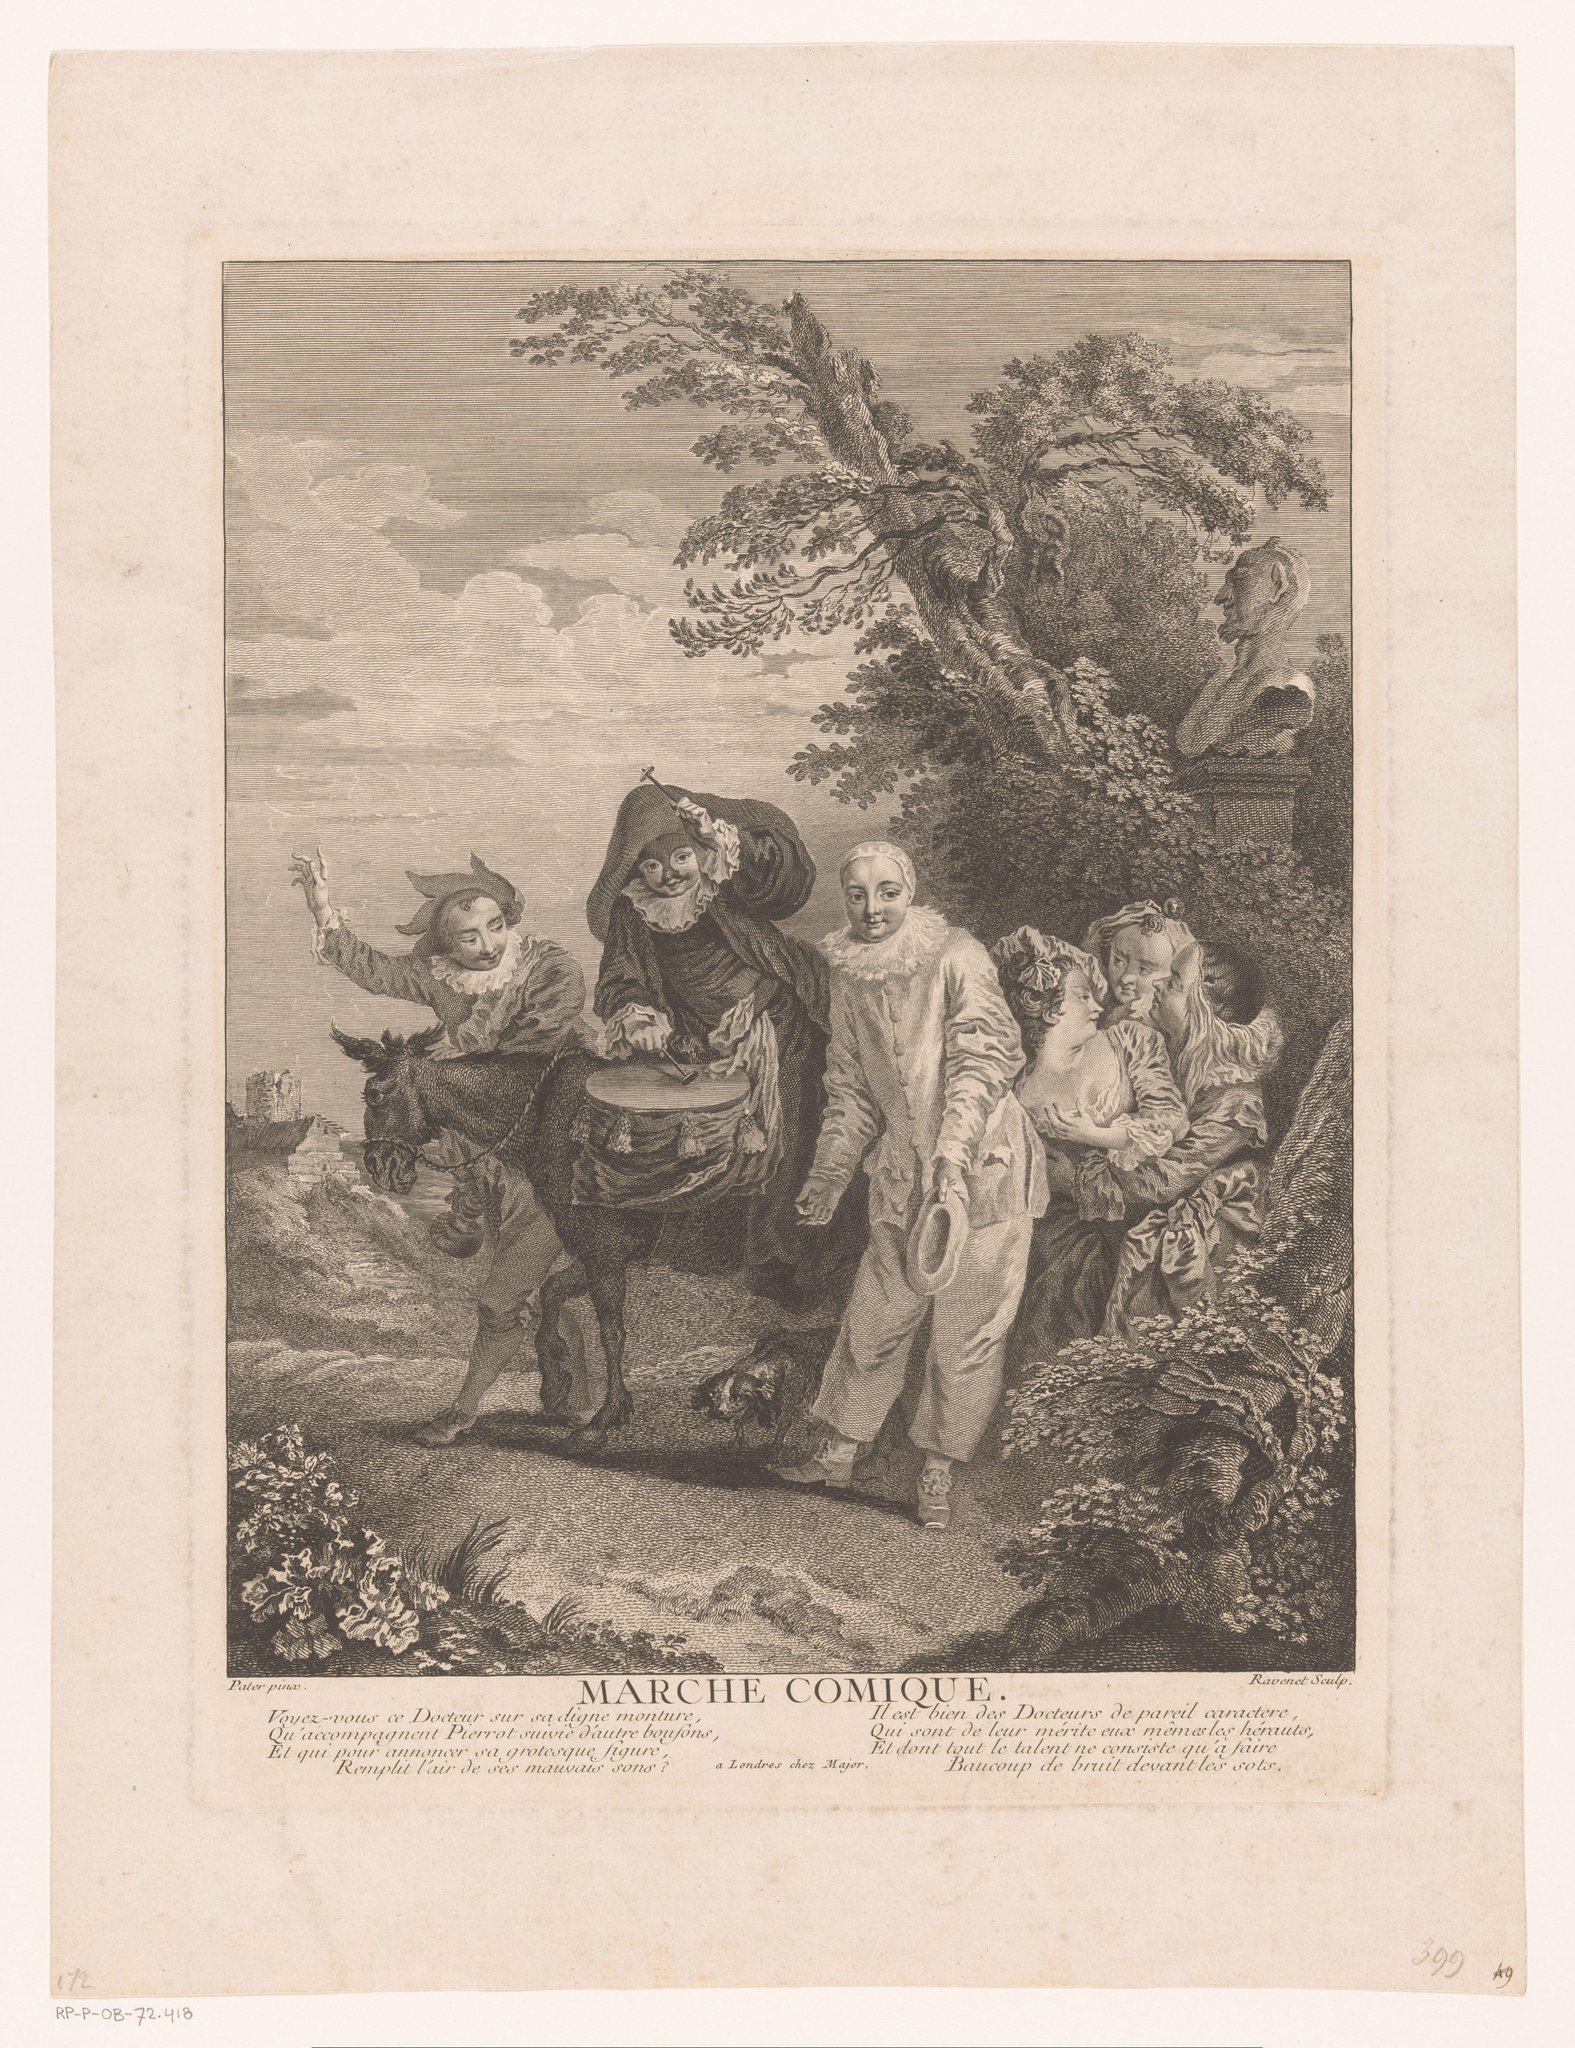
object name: print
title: Marche Comique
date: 1716-1774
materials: paper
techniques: engraving, etching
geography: london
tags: types in 'commedia dell'arte'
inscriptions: collector's mark: Lugt 2228